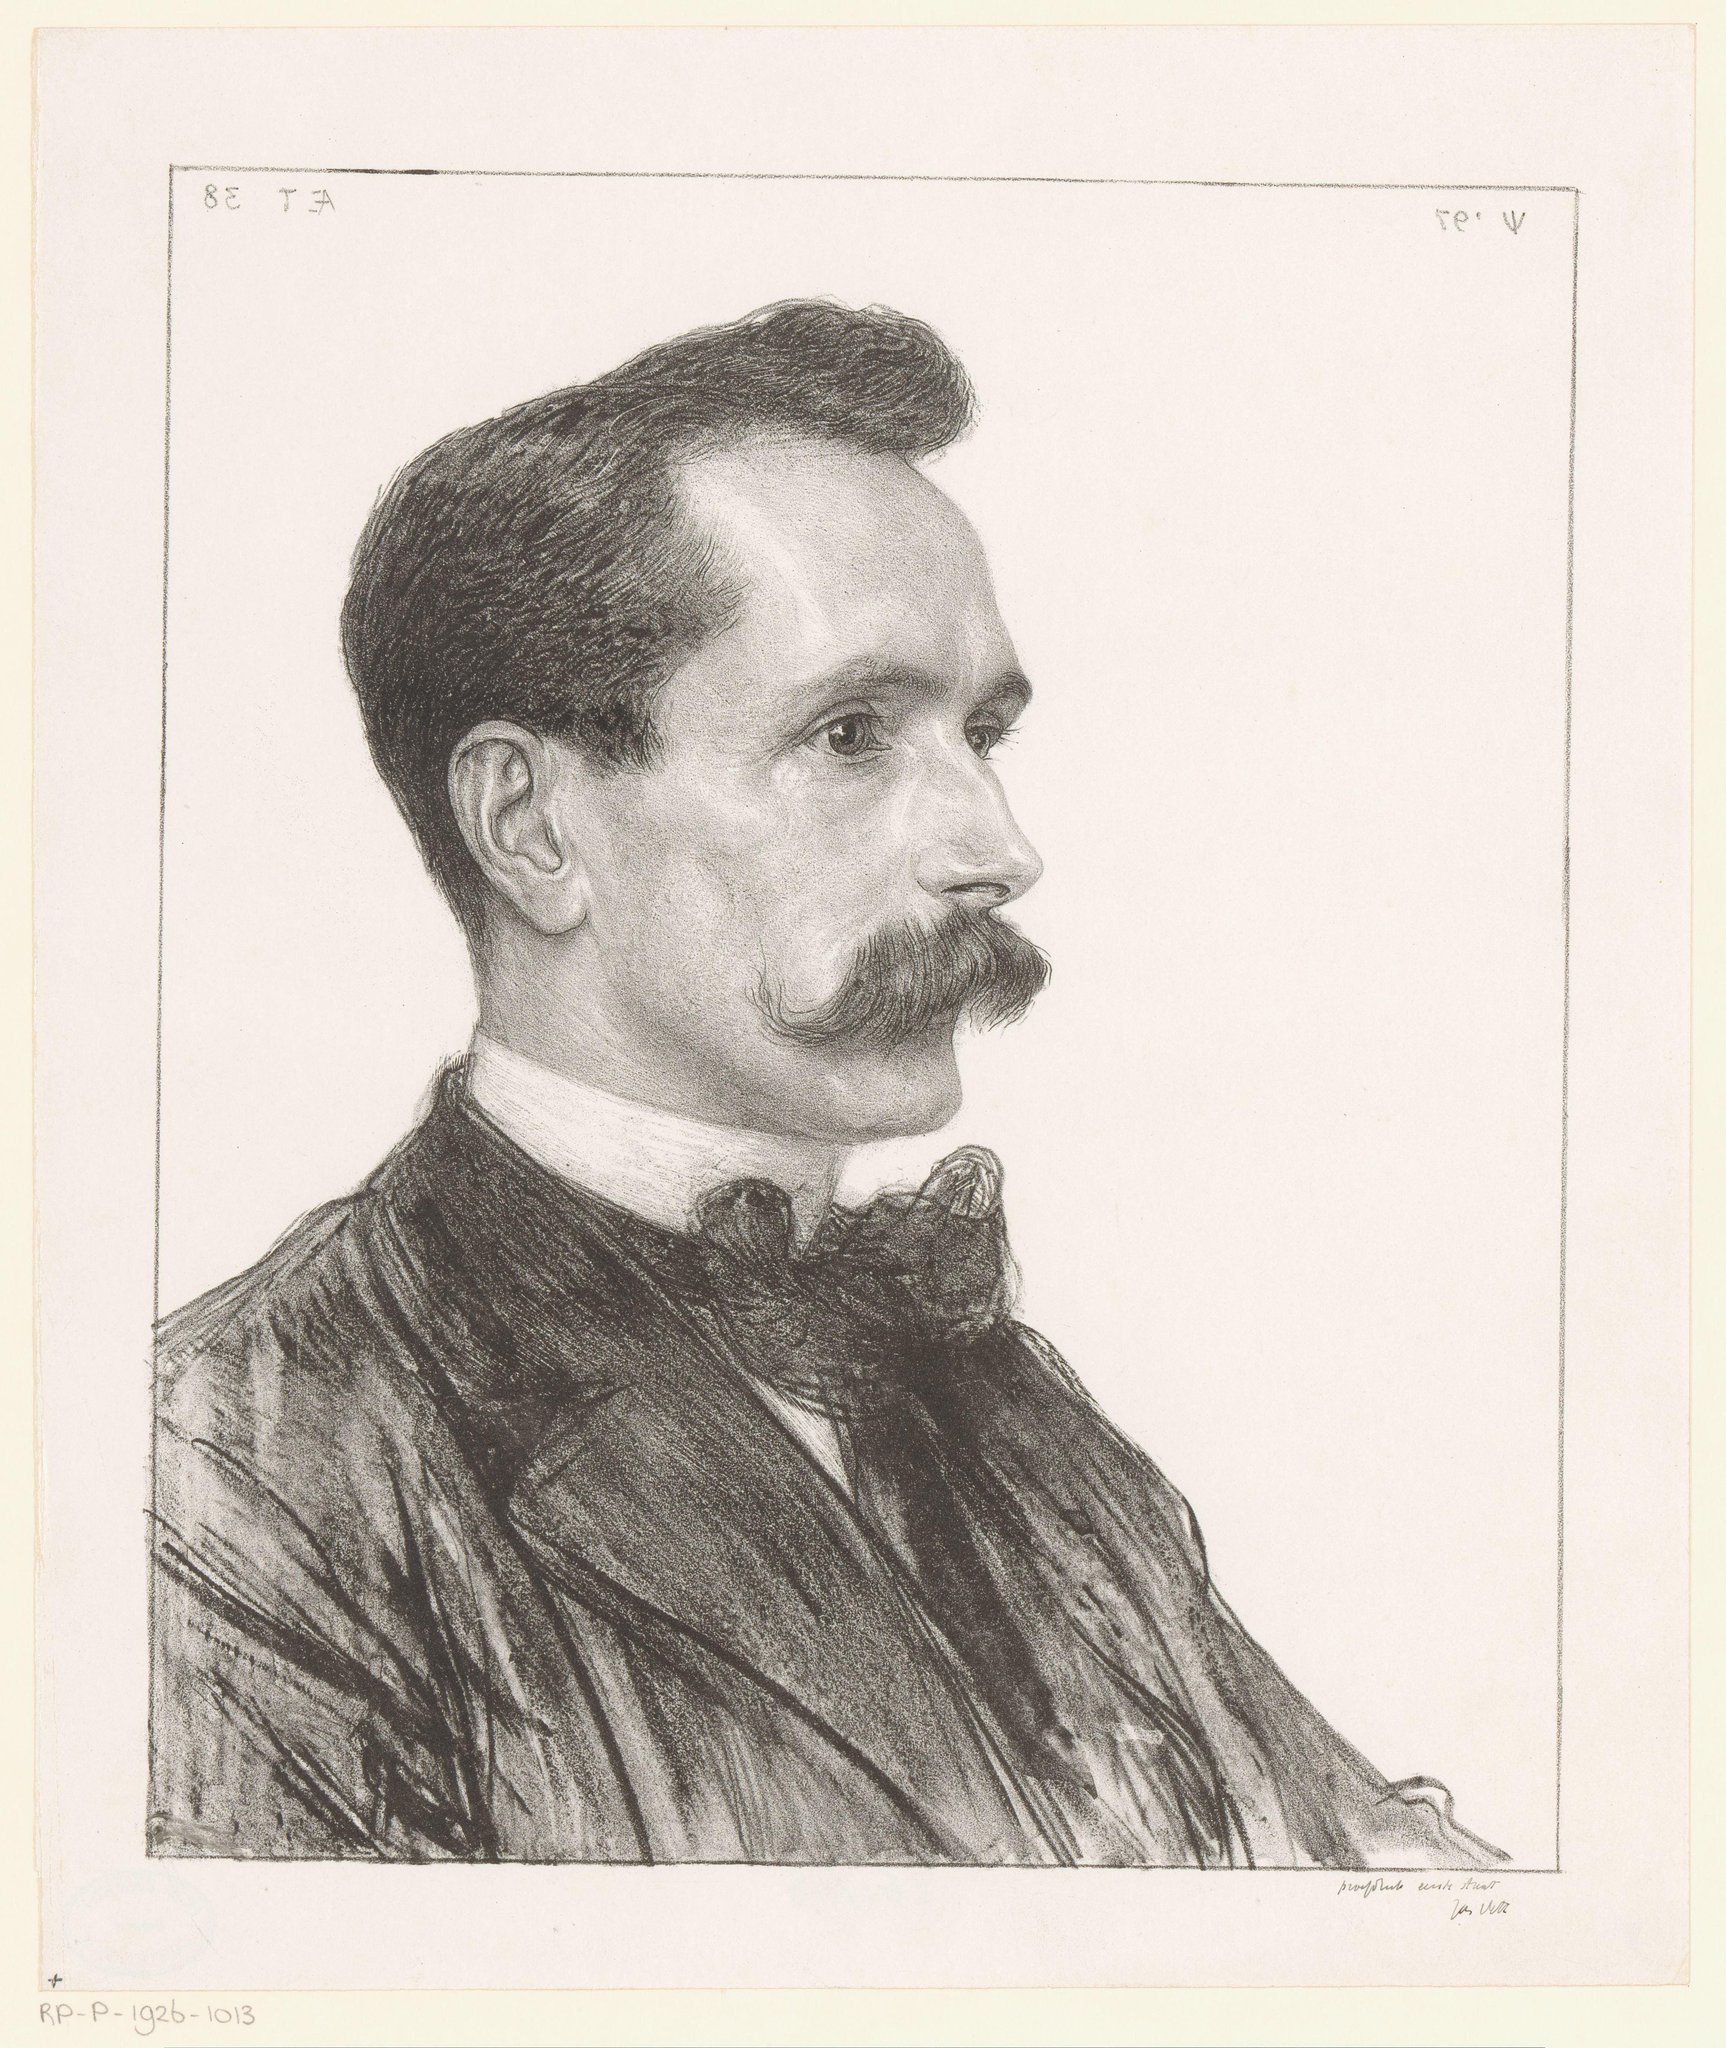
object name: print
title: Portret van Willem Treub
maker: jan veth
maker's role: designer, draughtsman, painter, print maker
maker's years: 1864-1925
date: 1897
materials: paper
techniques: lithograph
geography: netherlands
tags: historical persons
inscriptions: inscription: ‘proefdruk eerste staat / Jan Veth’, collector's mark: Lugt 2228, collector's mark: ‘H.G. Samson Amsterdam’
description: Dit portret werd uitgegeven als bijvoegsel bij De Kroniek op 30 mei 1897.